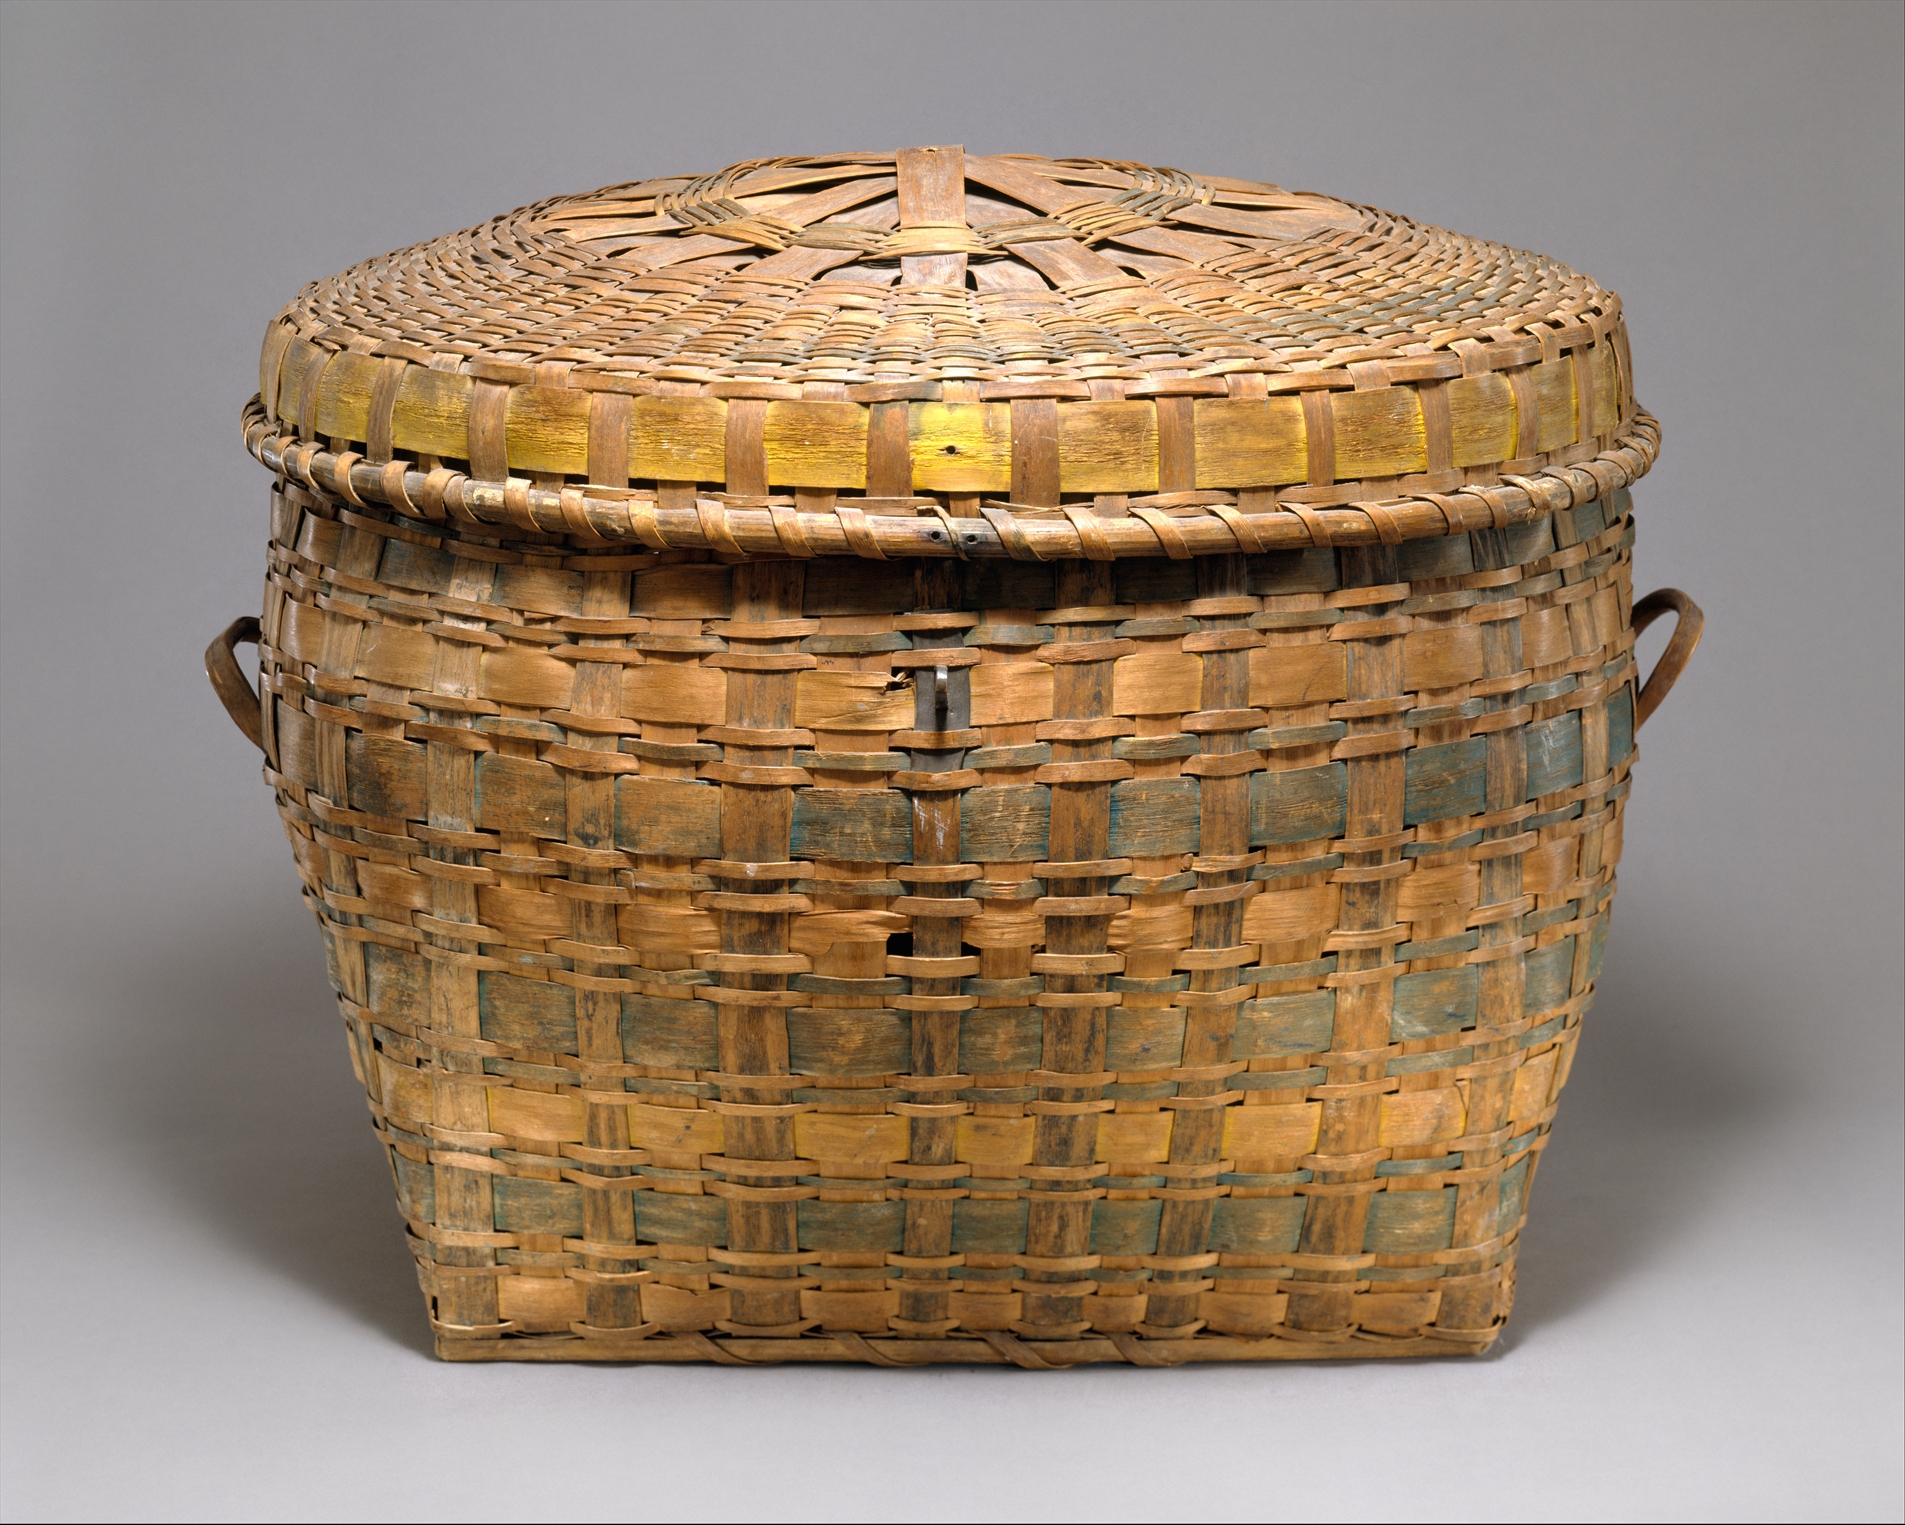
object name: basket with lid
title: Lidded Storage Basket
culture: passamaquoddy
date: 1840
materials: wood, pigment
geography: united states